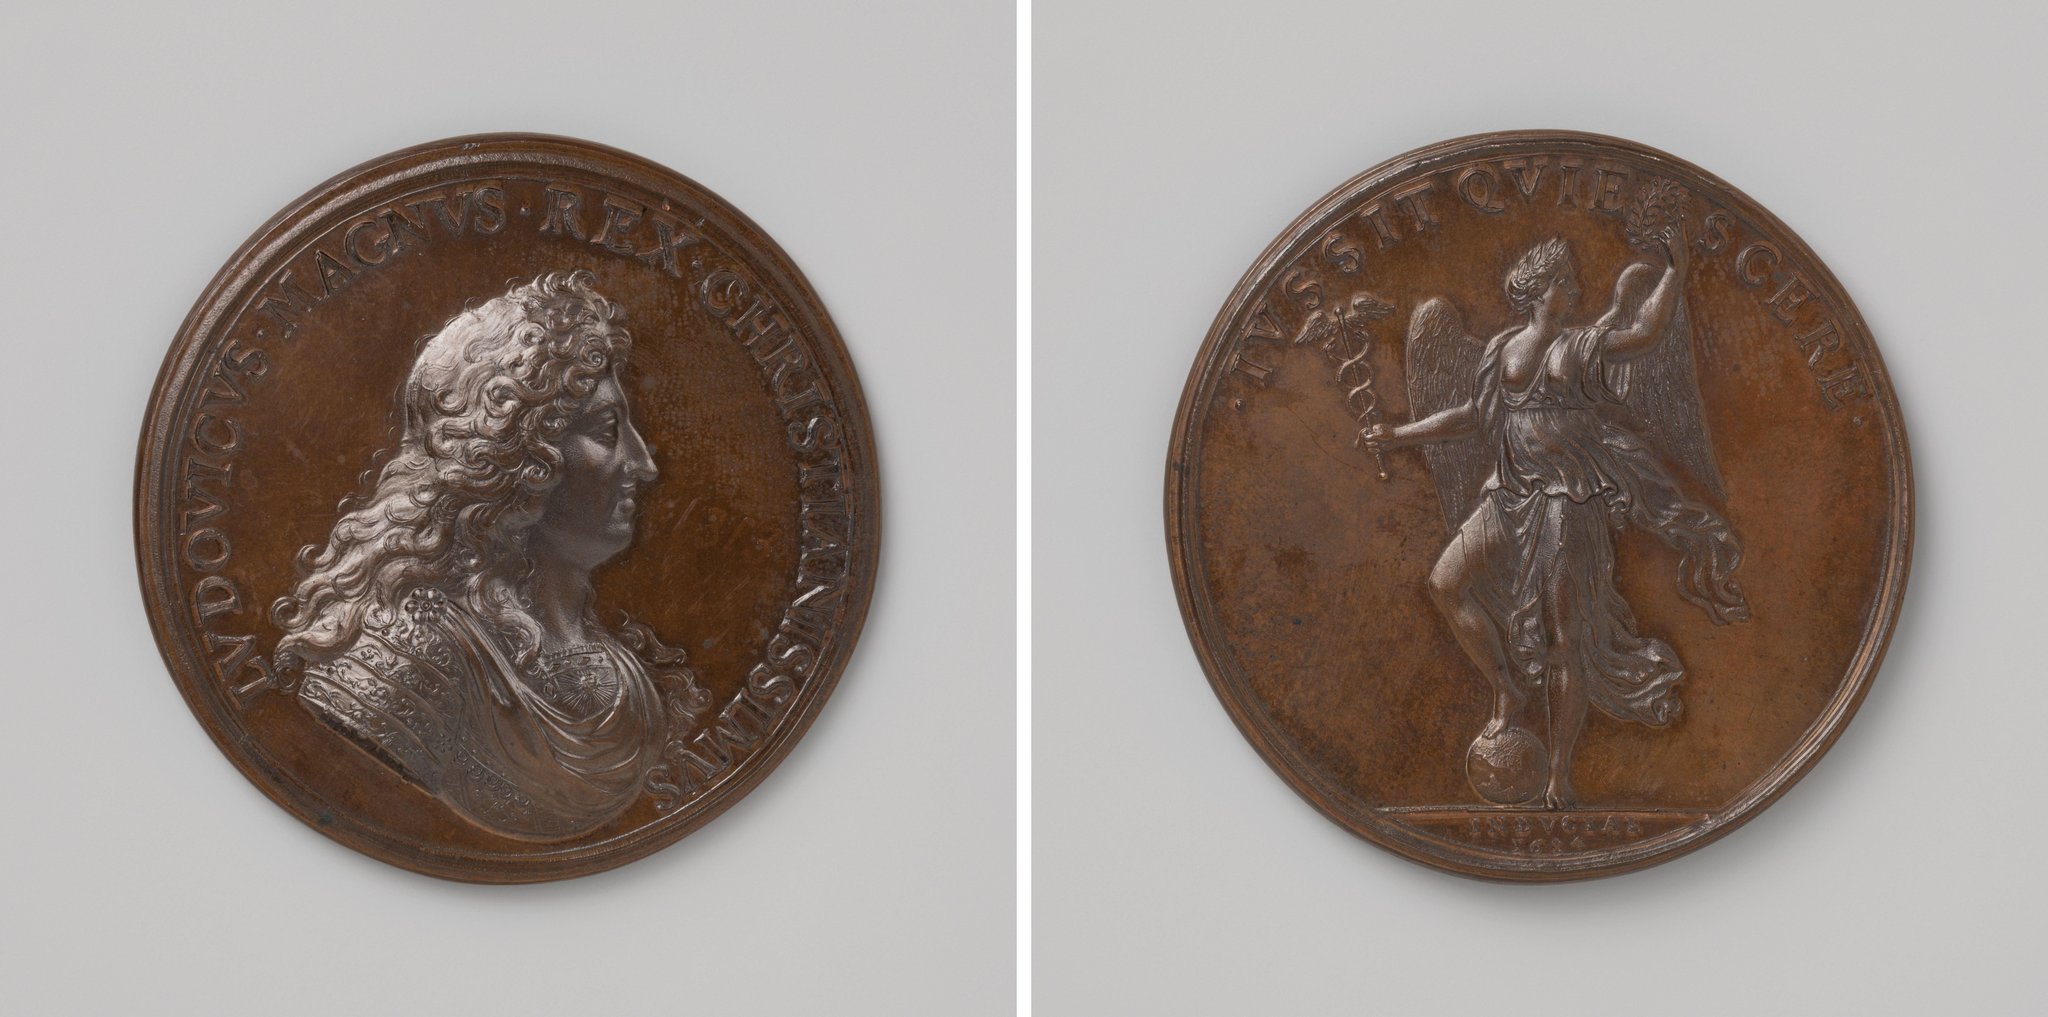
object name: history medal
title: Twintigjarige bestand van Regensburg tussen Frankrijk, de Keizer, Spanje en de Nederlanden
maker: michel molard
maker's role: medailleur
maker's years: 1641-1713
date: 1684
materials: bronze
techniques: striking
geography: paris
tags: lodewijk xiv (koning van frankrijk)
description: Bronzen penning. Voorzijde: borststuk man binnen omschrift. Keerzijde: Overwinning met Mercuriusstaf en lauwerkrans staand met een voet op wereldbol binnen omschrift; afsnede: opschrift